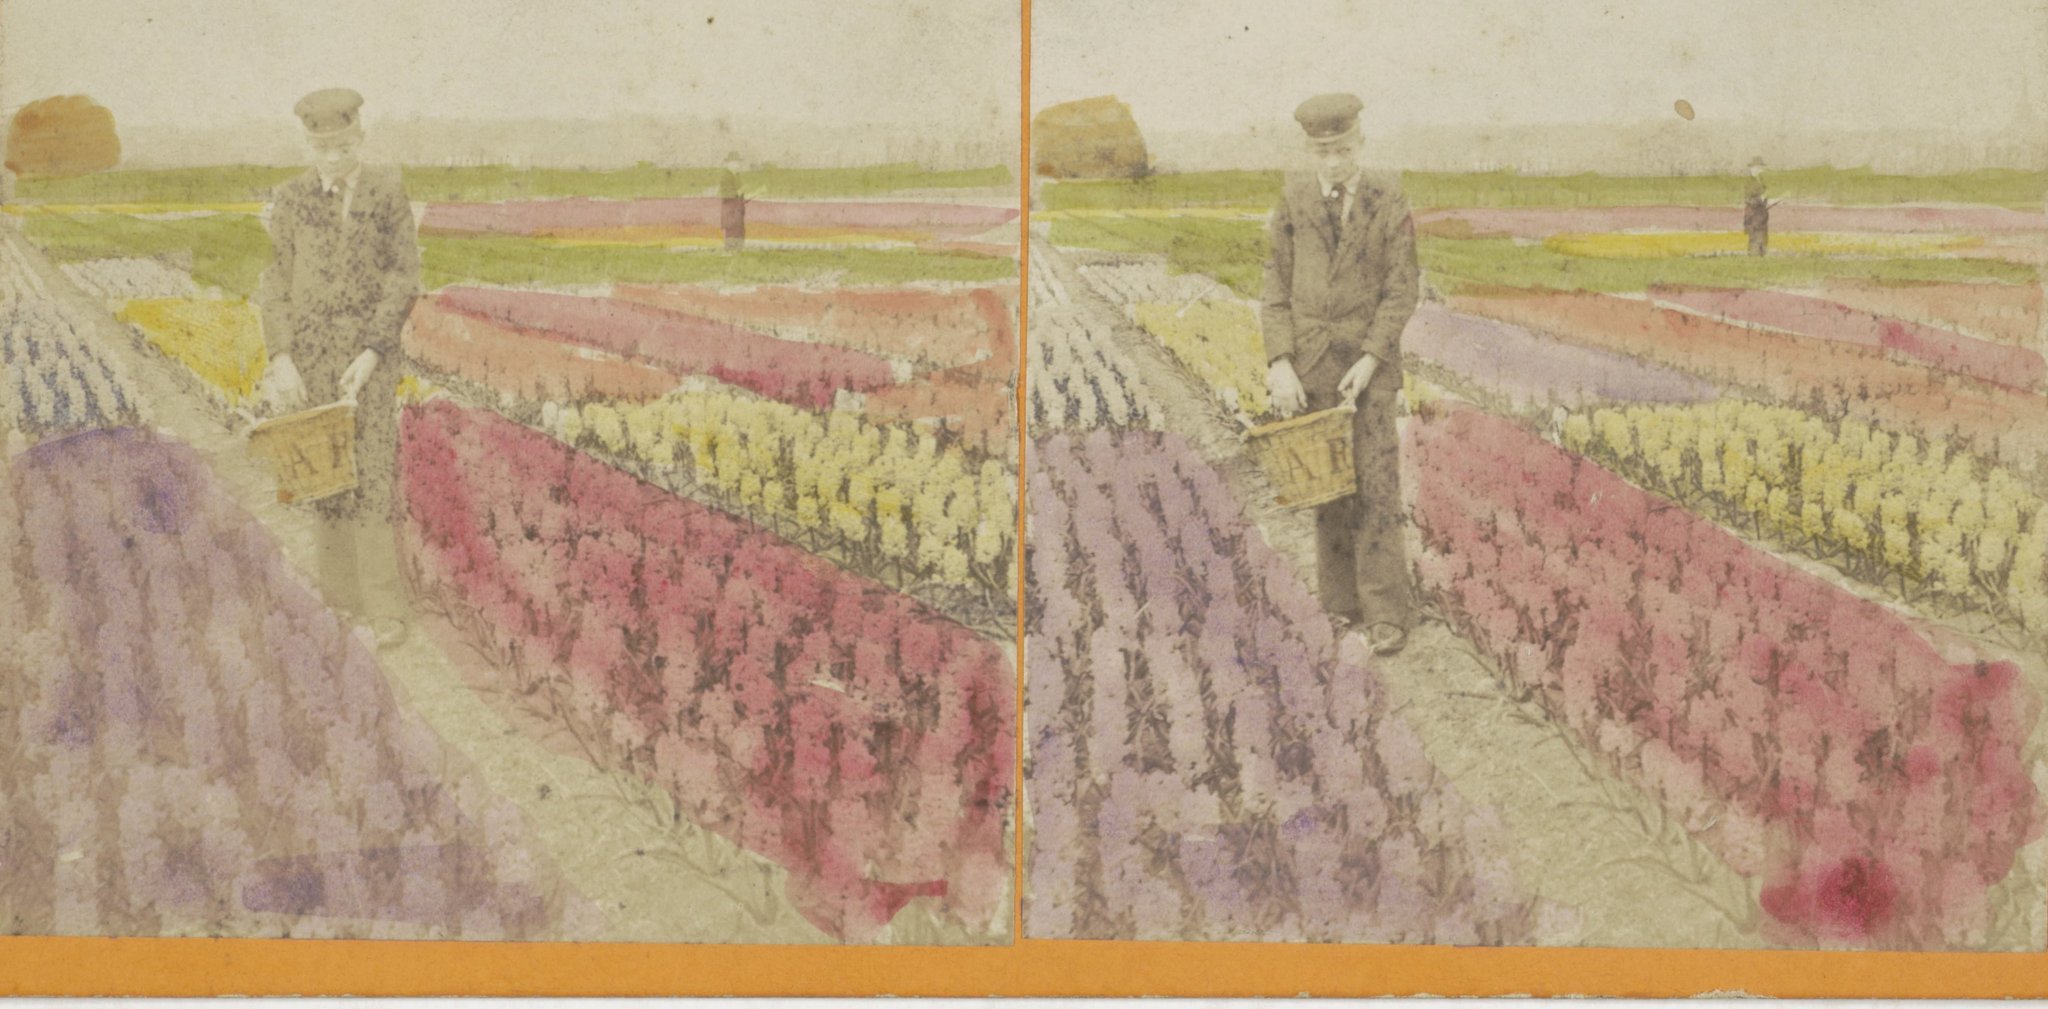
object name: stereograph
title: Gezicht op een bloembollenveld in de Bollenstreek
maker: Anonymous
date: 1873-1890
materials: cardboard, paper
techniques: albumen print, hand coloring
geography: bollenstreek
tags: bulb field, adult man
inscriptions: inscription: ‘1-’